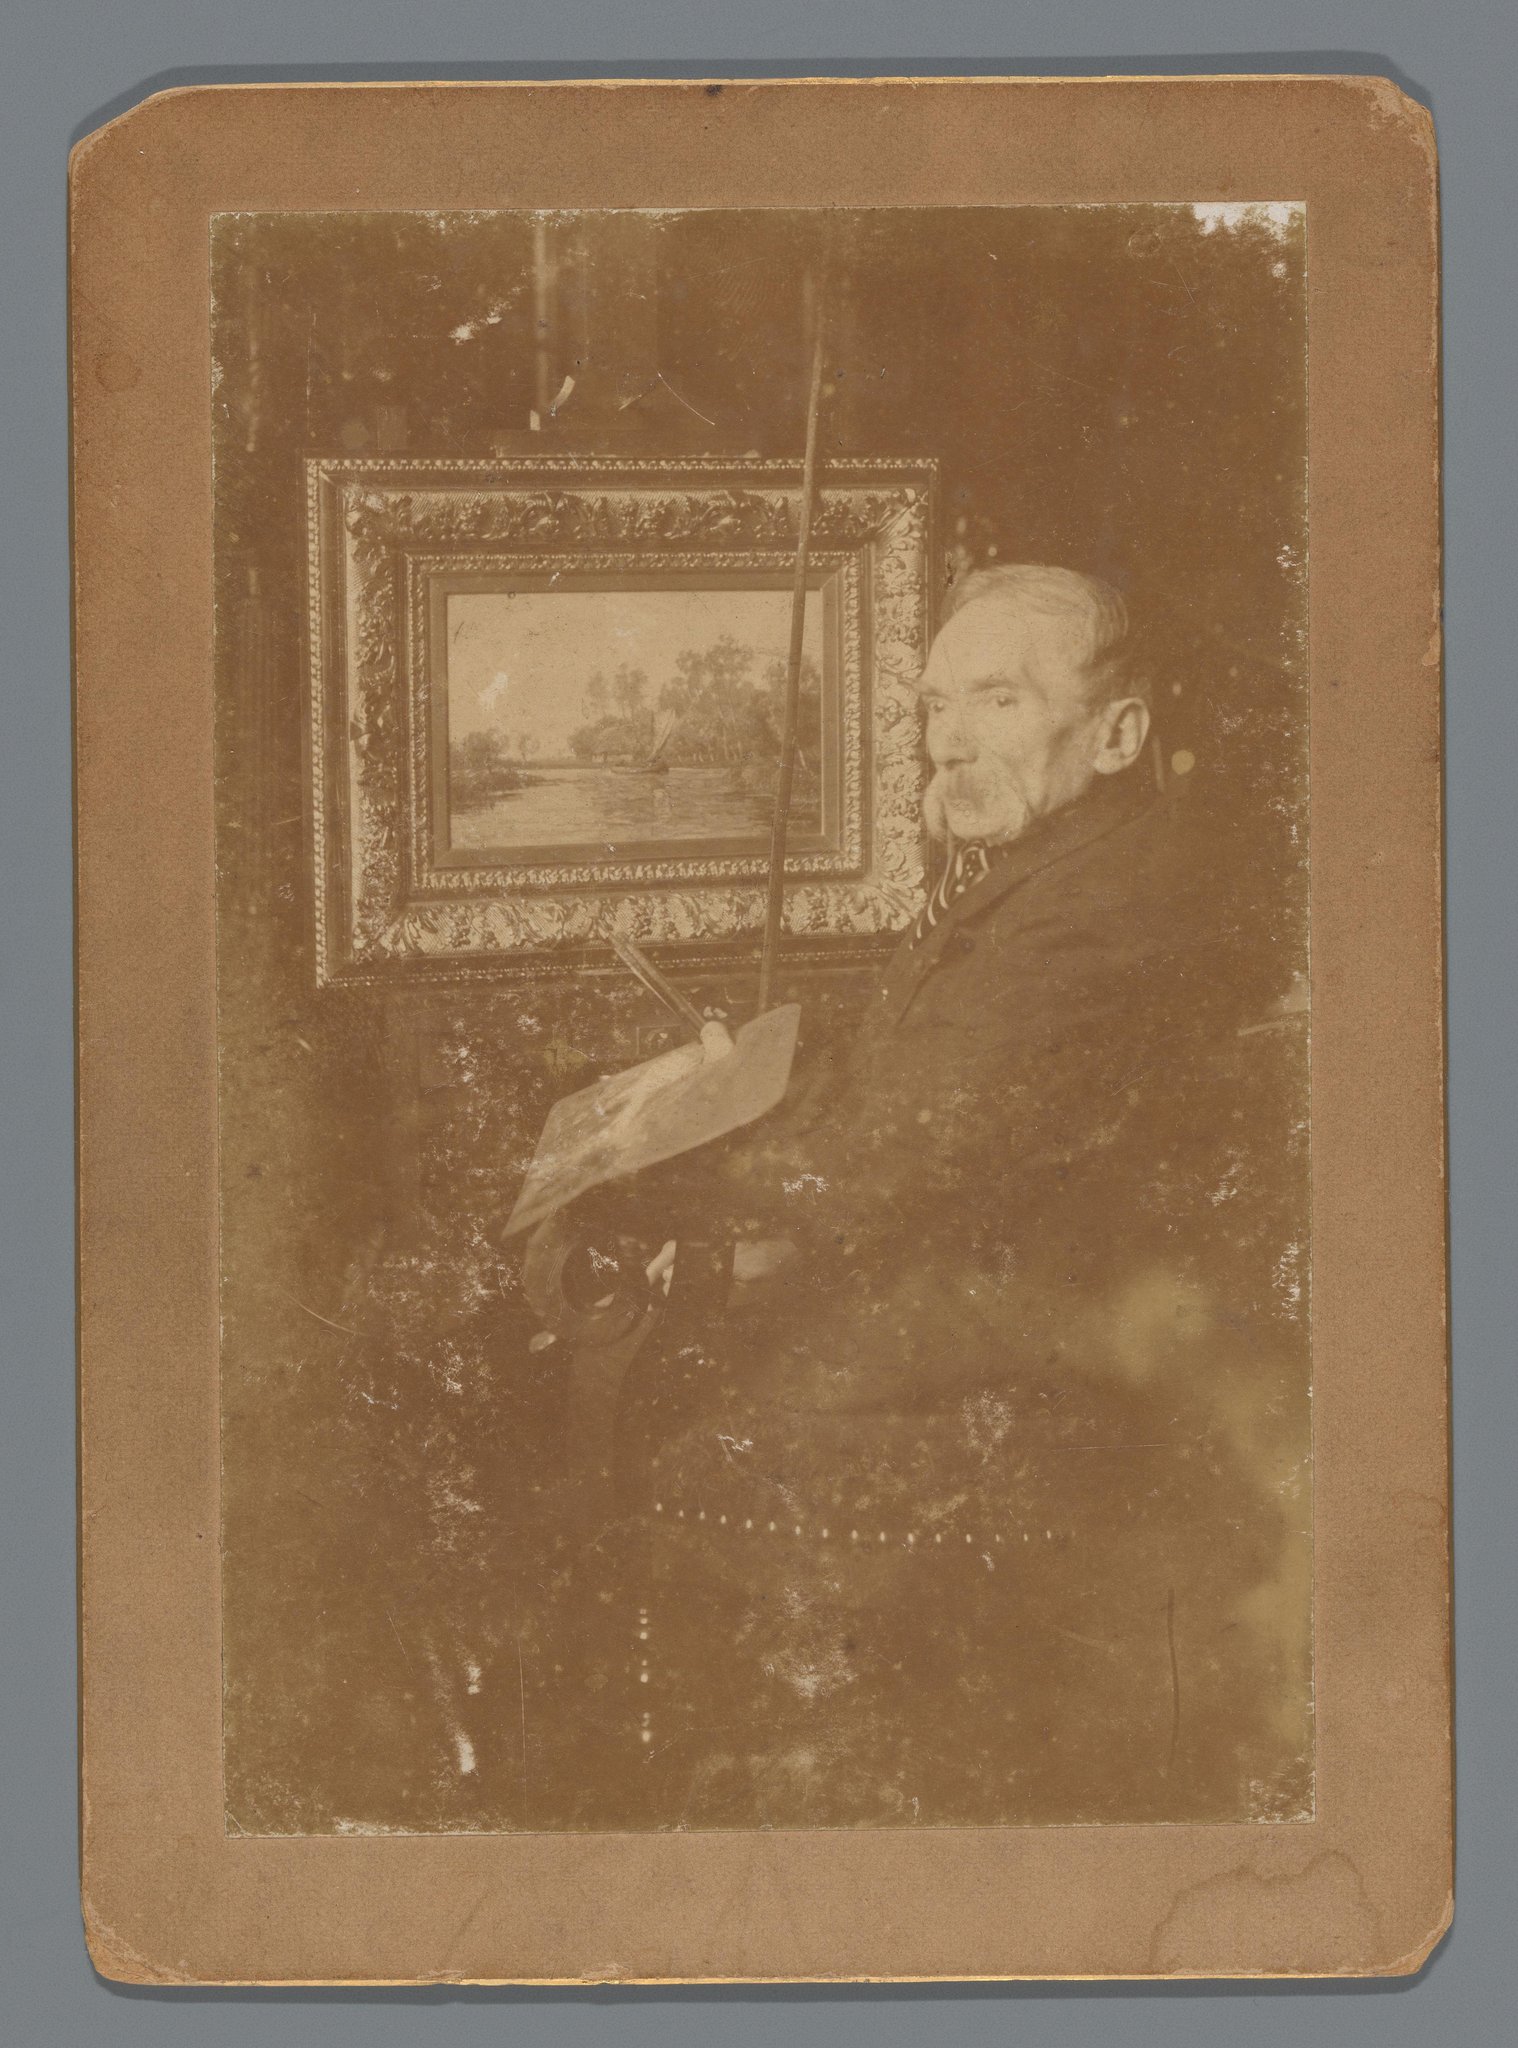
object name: photograph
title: Portret van Jan Willem van Borselen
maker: Anonymous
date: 1890-1892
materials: paper, cardboard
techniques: gelatin silver print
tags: gouda, the hague, print maker, draughtsman, jan willem van borselen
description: Portret van de schilder Jan Willem van Borselen, met palet in de hand achter een schildersezel gezeten